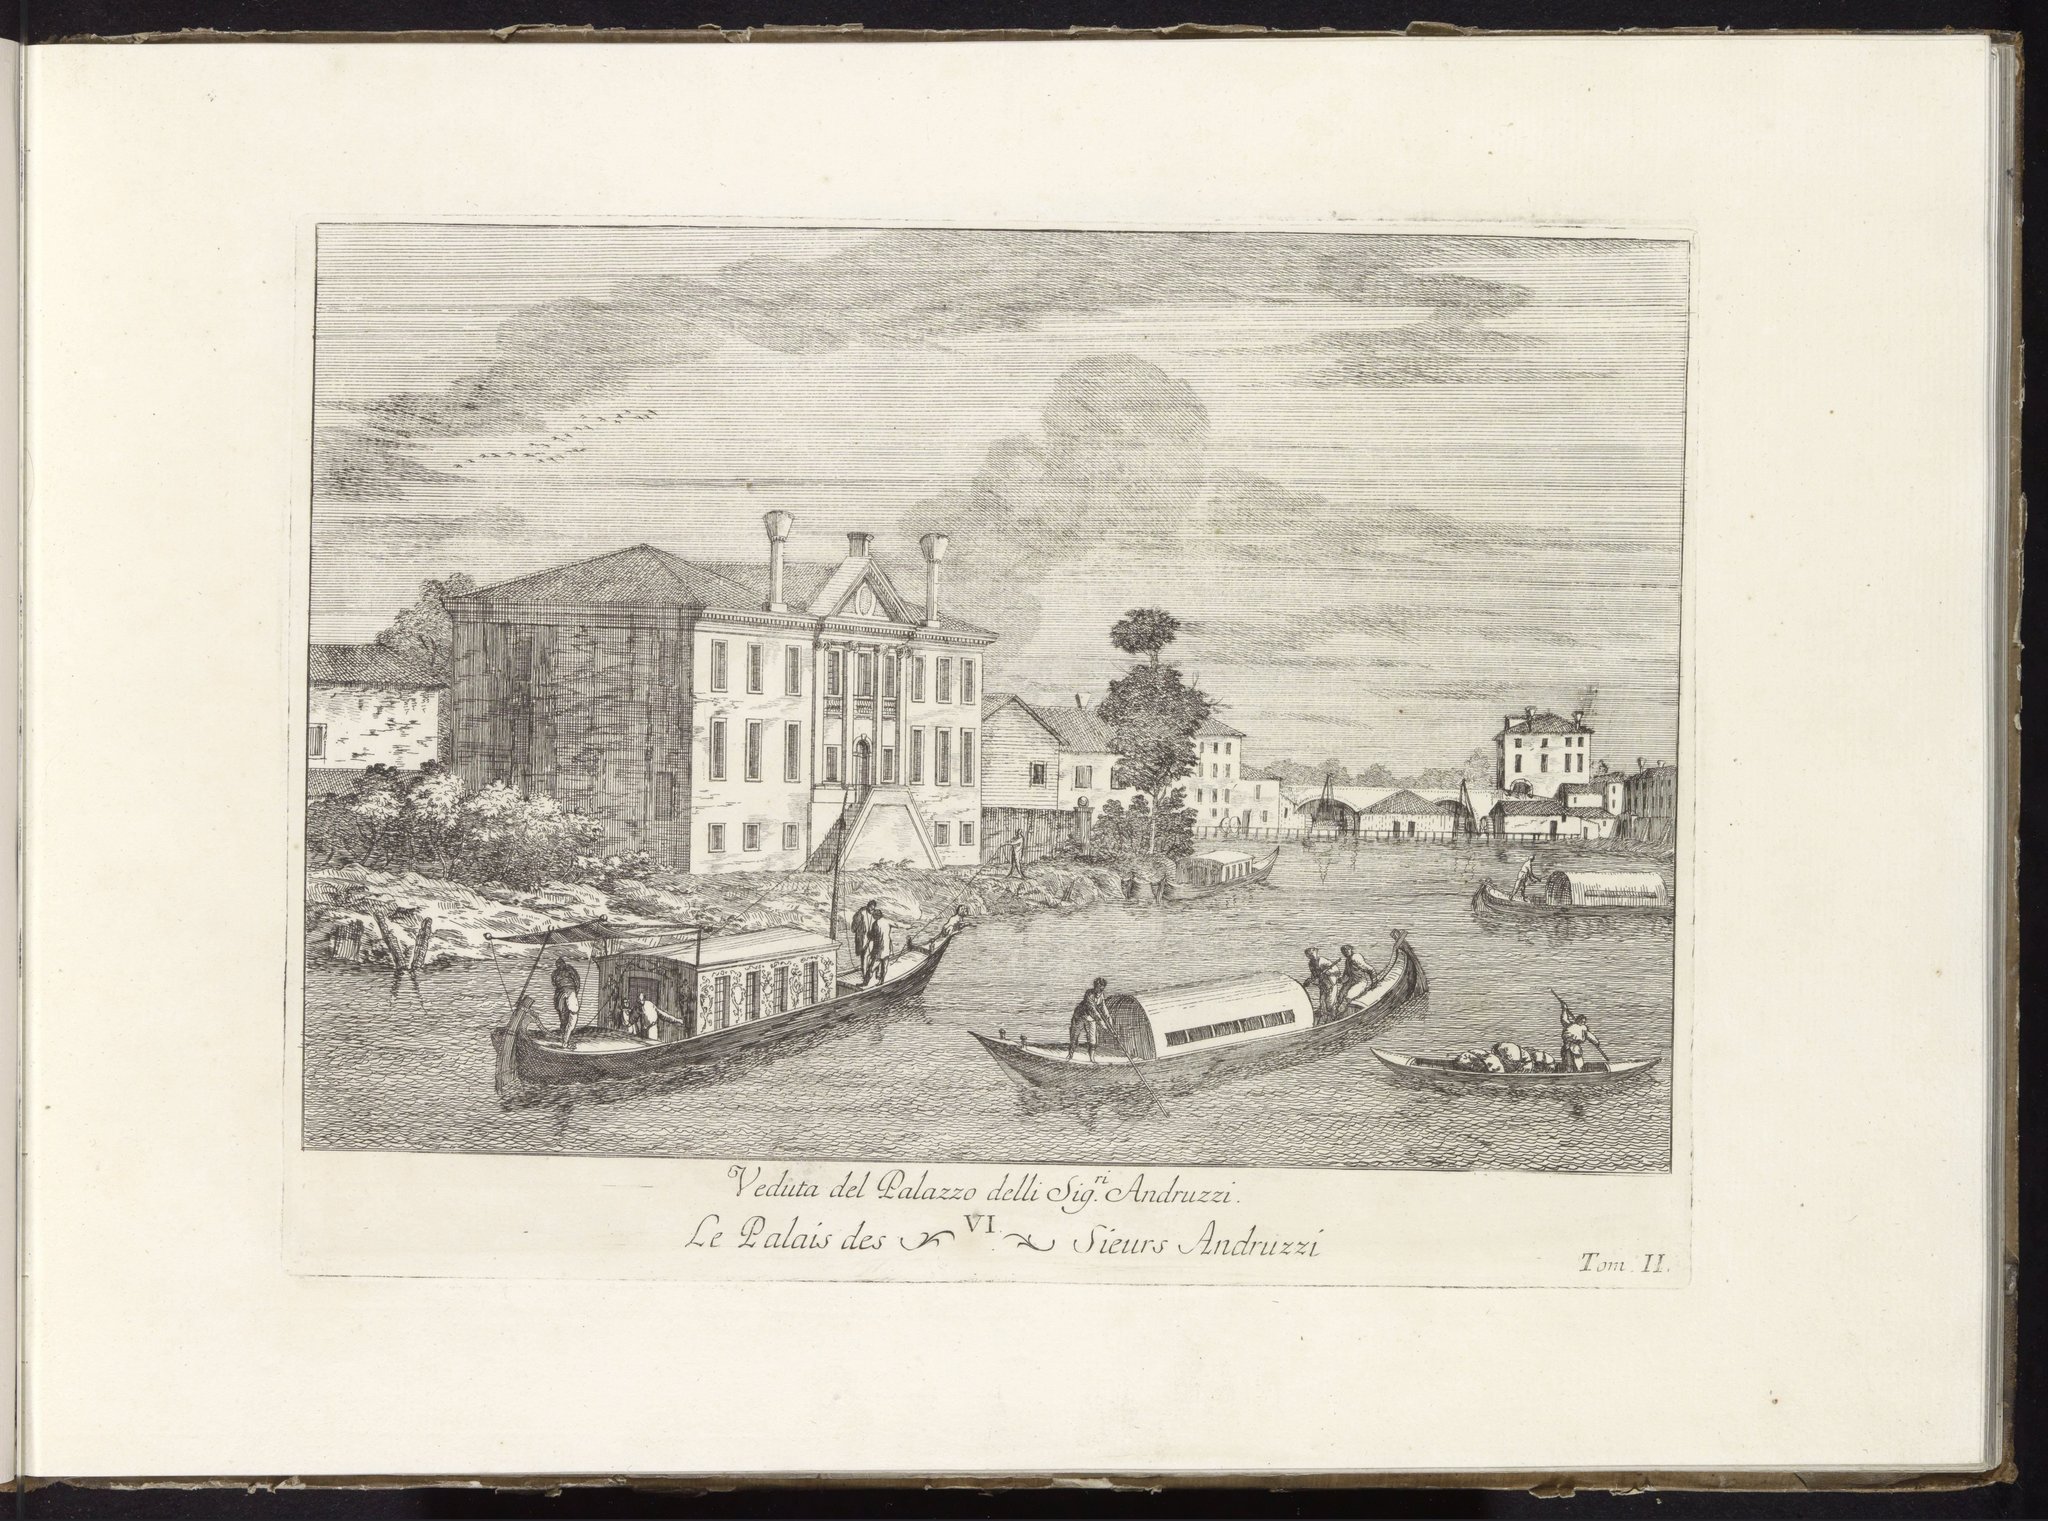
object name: print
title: Palazzo delli Signori Andruzzi aan de Brenta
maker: giovanni francesco costa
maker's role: draughtsman, painter, print maker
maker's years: -1773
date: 1750-1760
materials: paper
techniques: etching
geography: italy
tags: river, hôtel, i.e. small palace in city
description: Gezicht op Palazzo delli Signori Andruzzi aan de rivier de Brenta. op het water varen verschillende gondels. Genummerd midden onder: VI en rechtsonder: Tom: II. Deze prent maakt deel uit van een album.